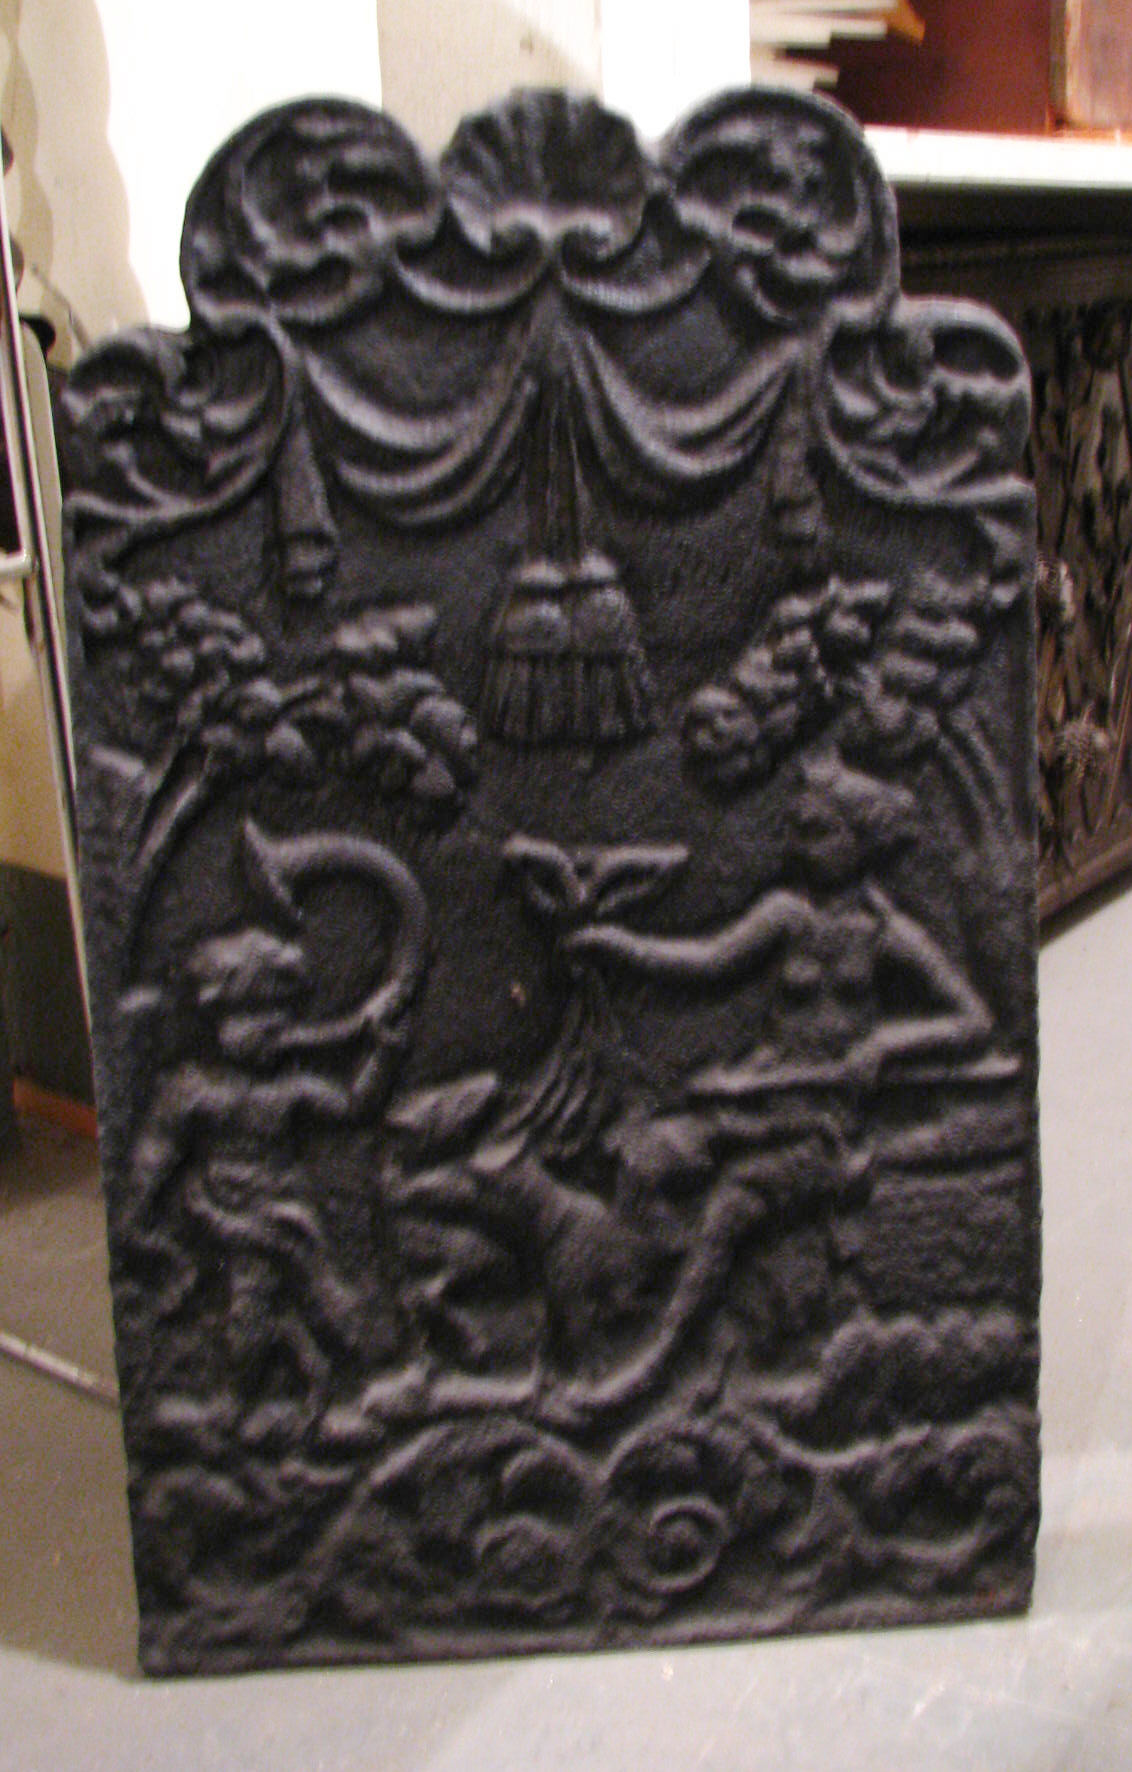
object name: fireback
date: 1701-1800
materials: iron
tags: human figures,horns,leaves